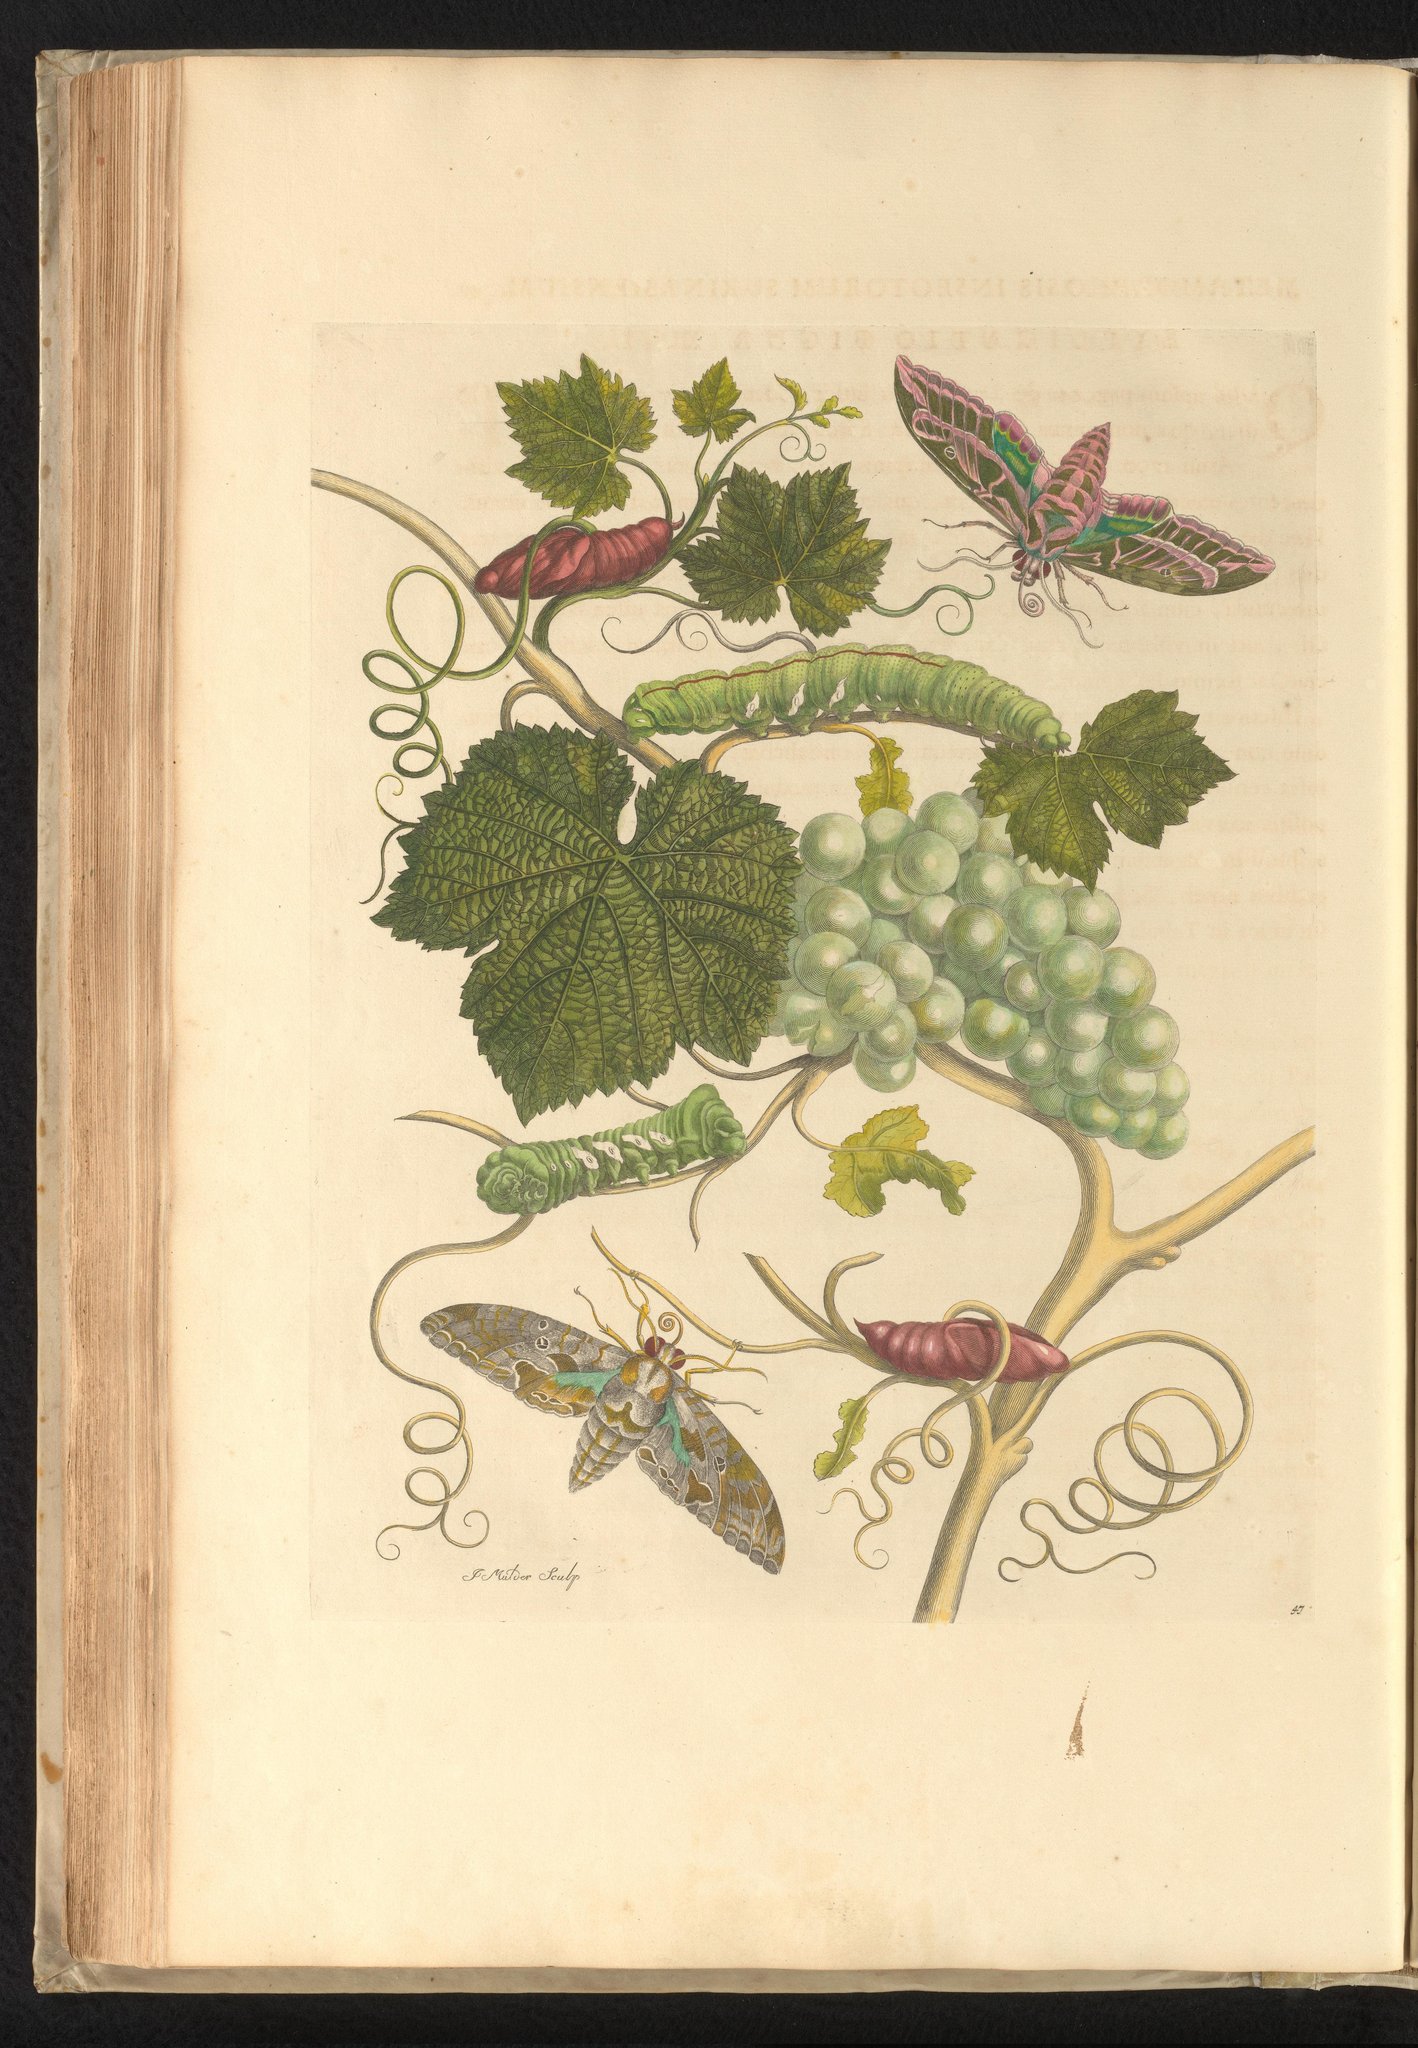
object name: page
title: Witte druiven (Vitis vinifera) met nachtvlinders, rupsen en poppen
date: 1705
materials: paper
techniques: etching, hand coloring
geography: amsterdam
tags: insects: pupa, fruits: grape, insects: moth, insects: caterpillar, suriname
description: Rechtsonder genummerd: 47. Prent maakt deel uit van een boek.